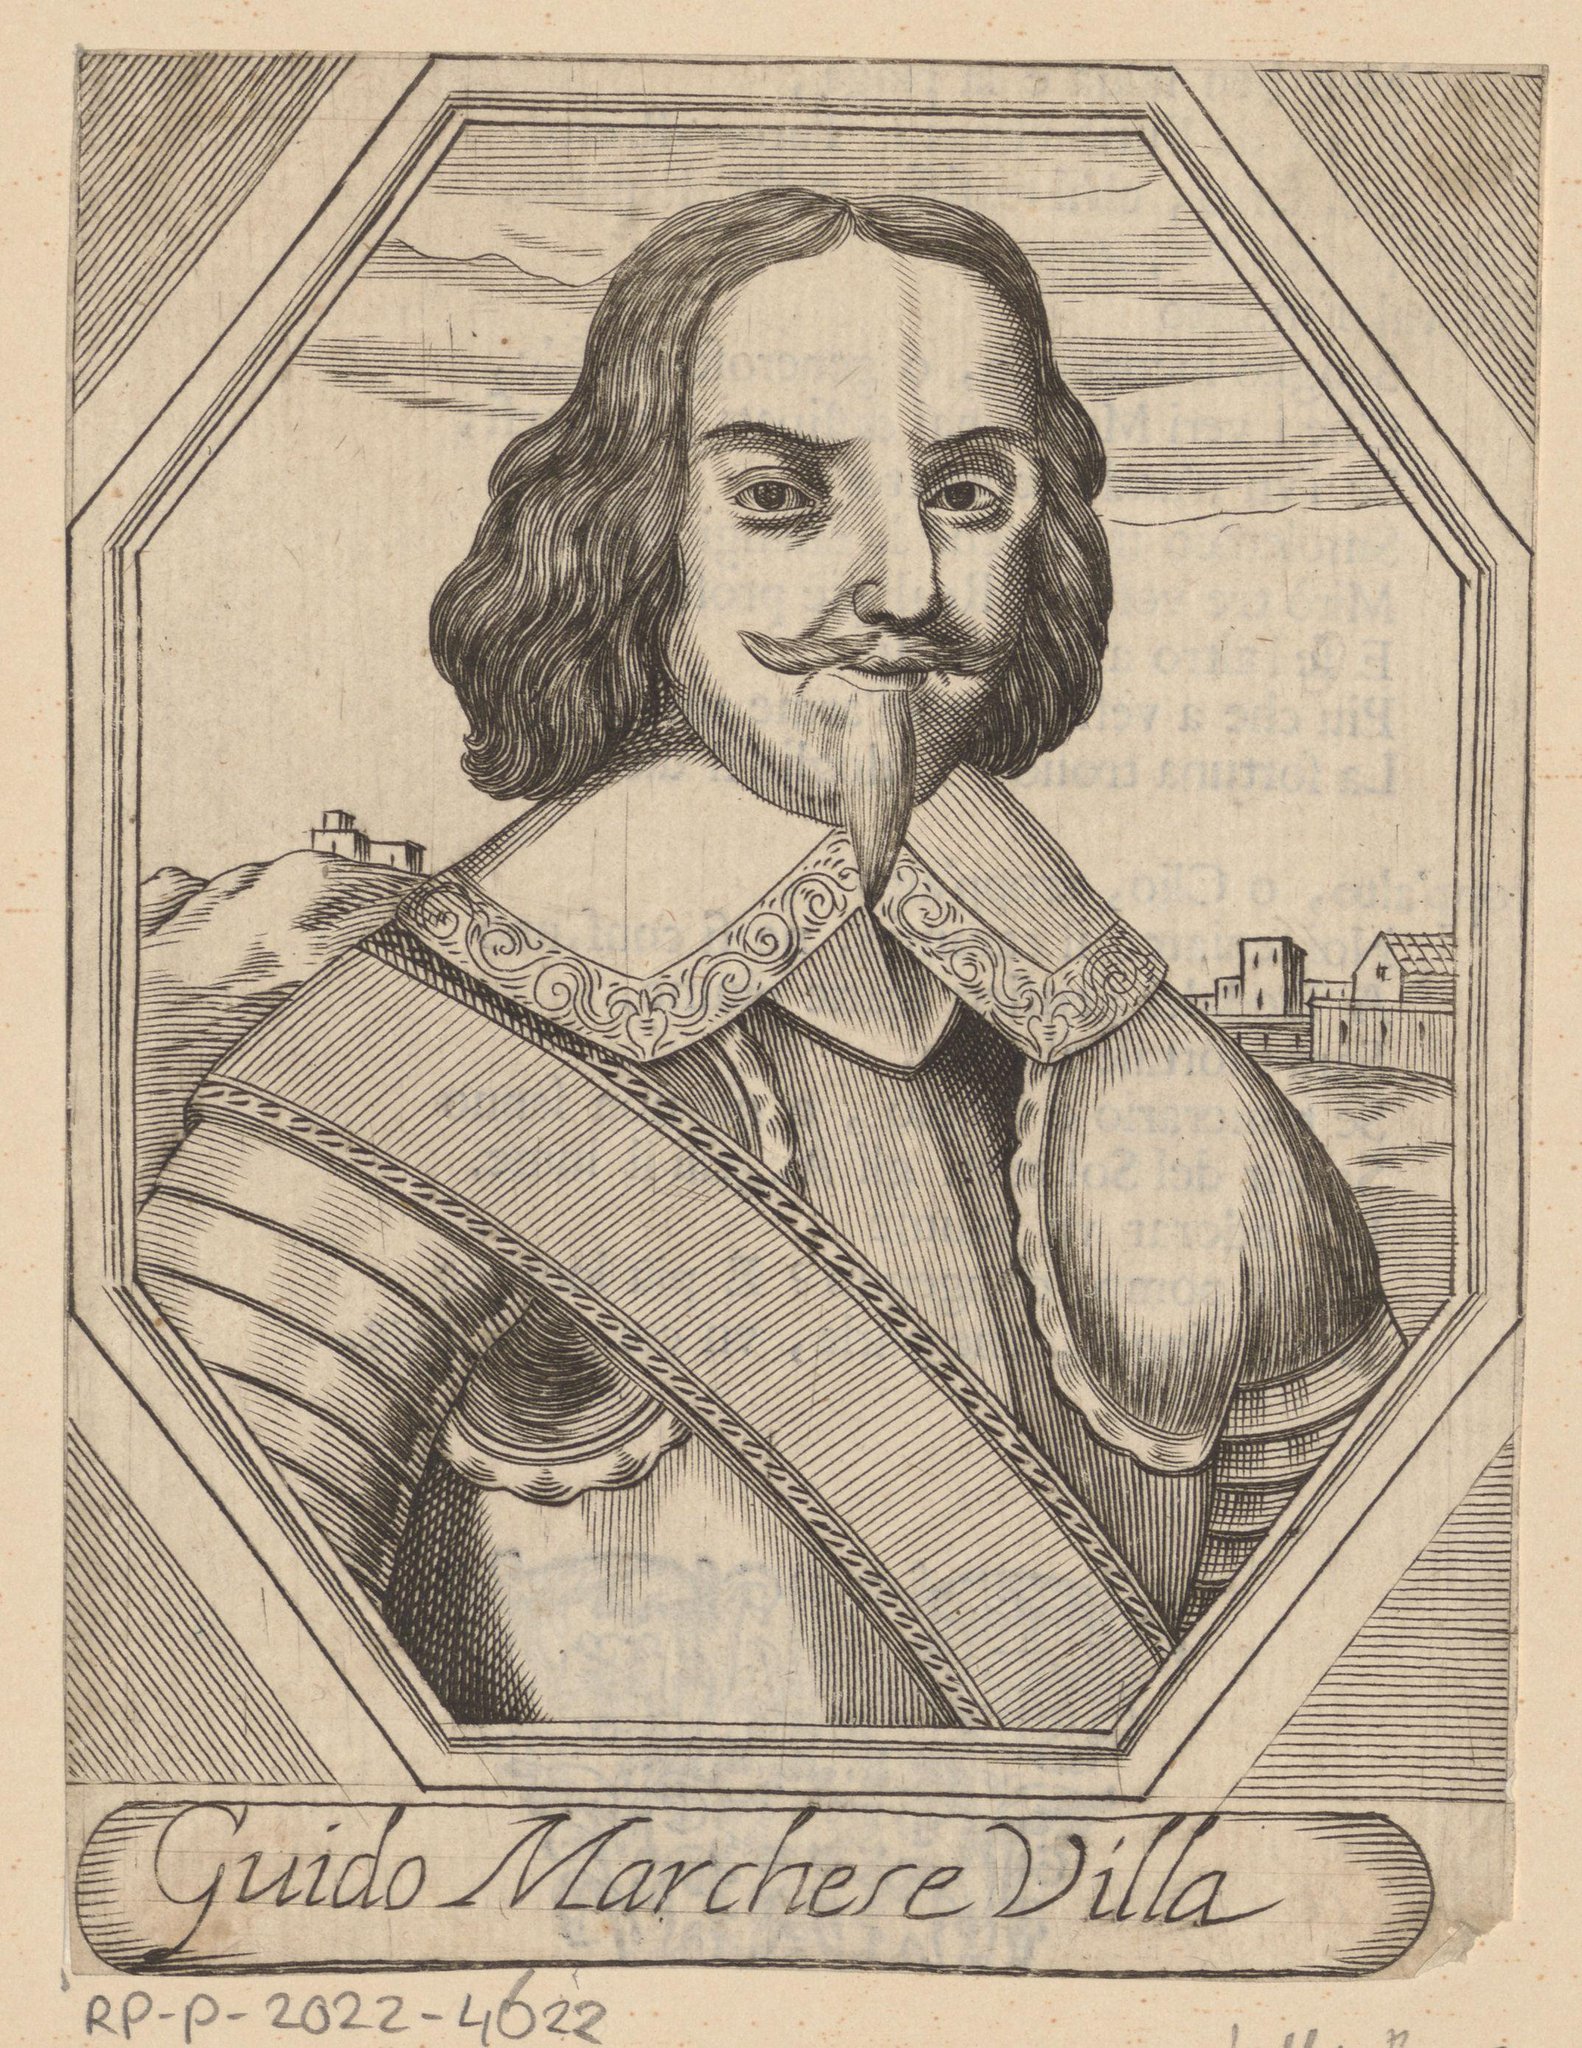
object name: print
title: Portret van Guido Villa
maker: Anonymous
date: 1683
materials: paper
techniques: engraving, letterpress printing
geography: venice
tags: commander-in-chief, general, marshal, historical persons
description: Prent uit: Crasso, Lorenzo. Elogii di capitani illustri. Venetië: Combi & La Noù, 1683, p. 248.